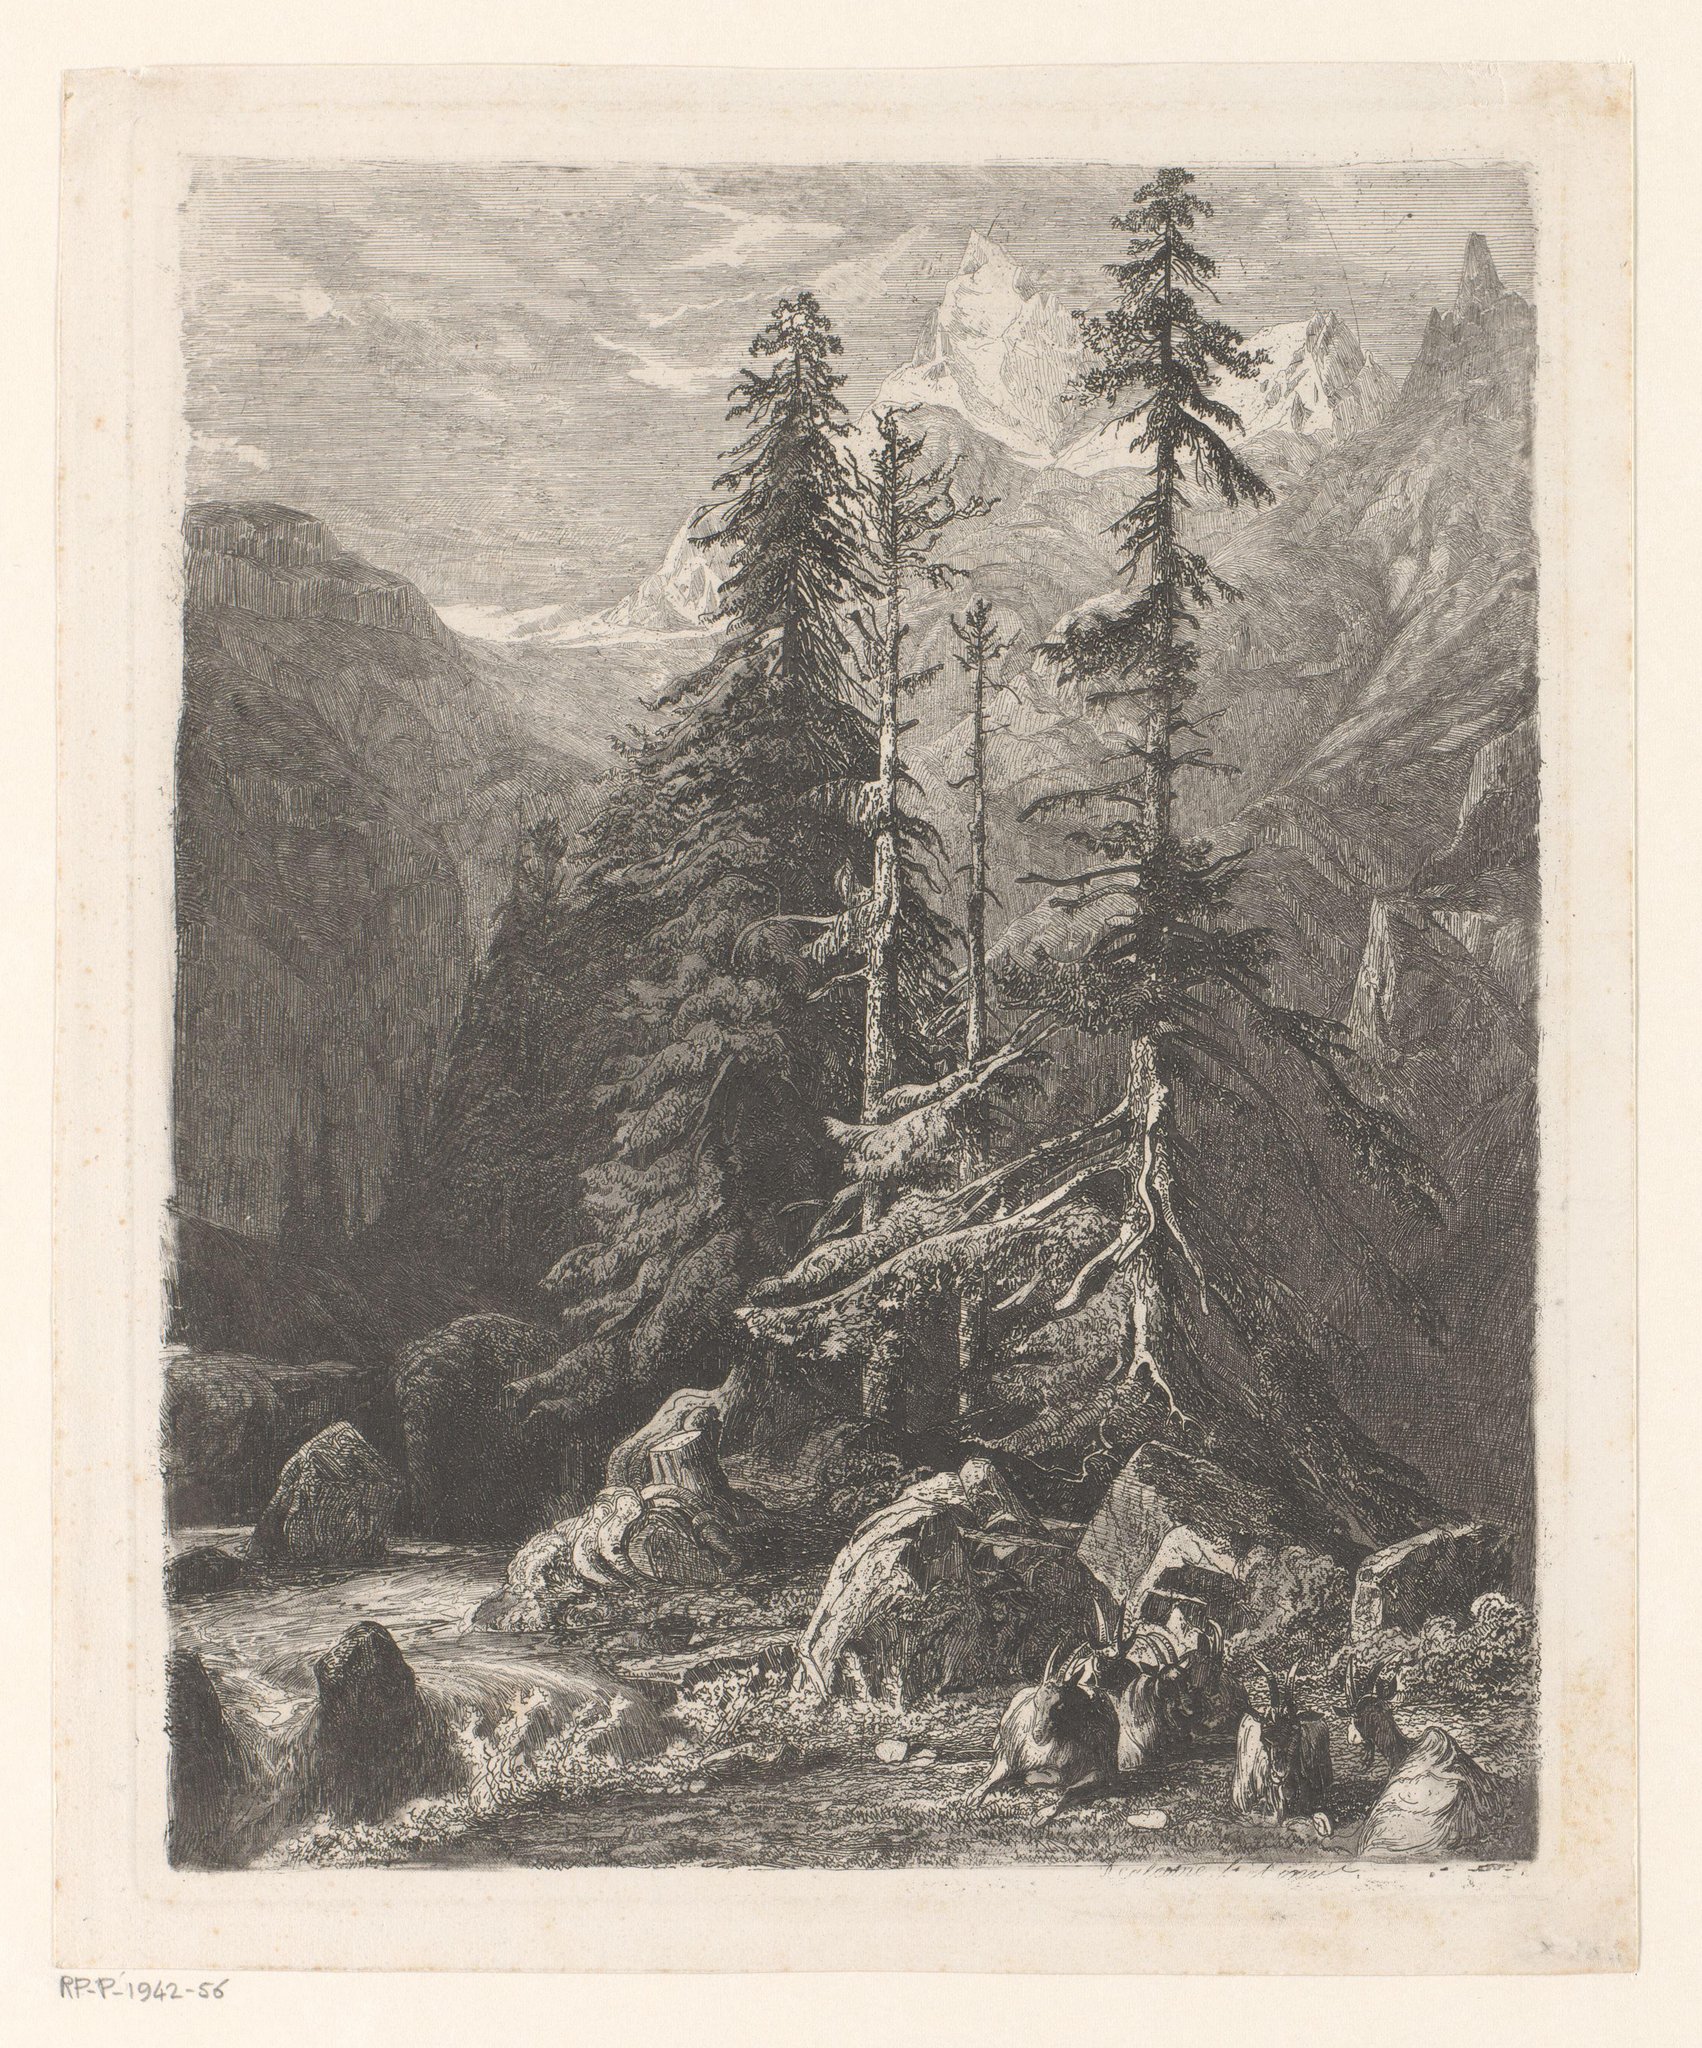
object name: print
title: Berglandschap met geiten bij een beek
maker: alexandre calame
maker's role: draughtsman, painter, print maker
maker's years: 1810-1864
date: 1820-1864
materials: paper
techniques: etching, roulette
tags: brook, goat, trees: pine, mountains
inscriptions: collector's mark: Lugt 138, collector's mark: Lugt 2760, collector's mark: Lugt 2228